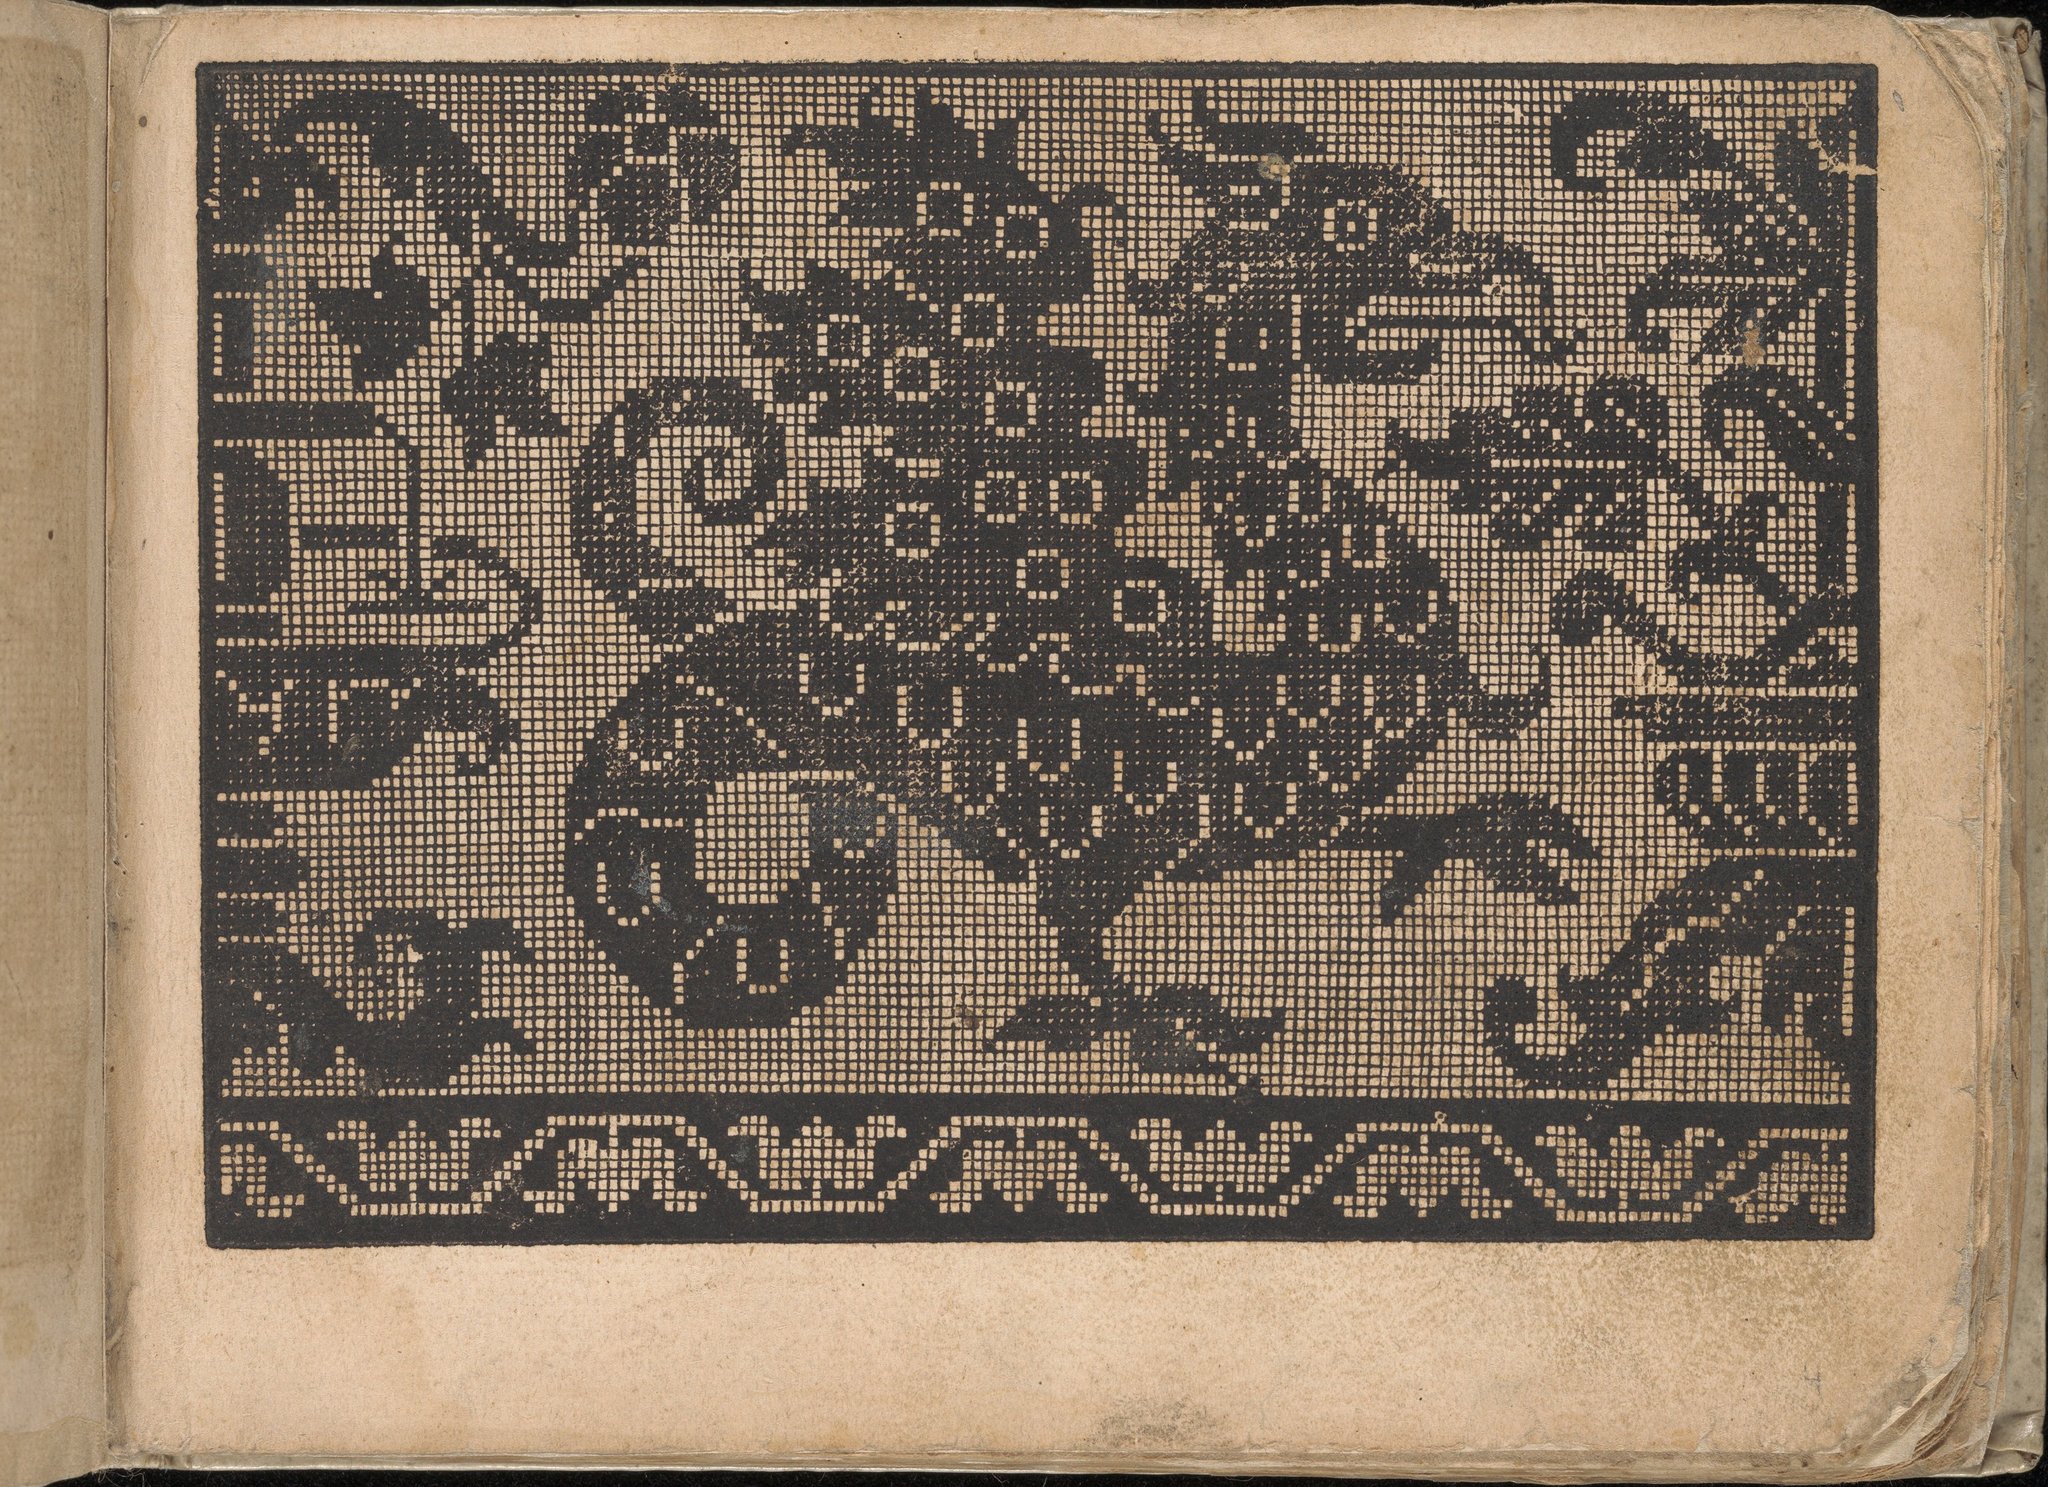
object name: book print ornament architecture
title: Neu künstlich Modelbuch (page 4r)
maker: bernhard jobin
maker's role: publisher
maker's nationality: swiss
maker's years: 1535-1597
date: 1598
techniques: woodcut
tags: ornament